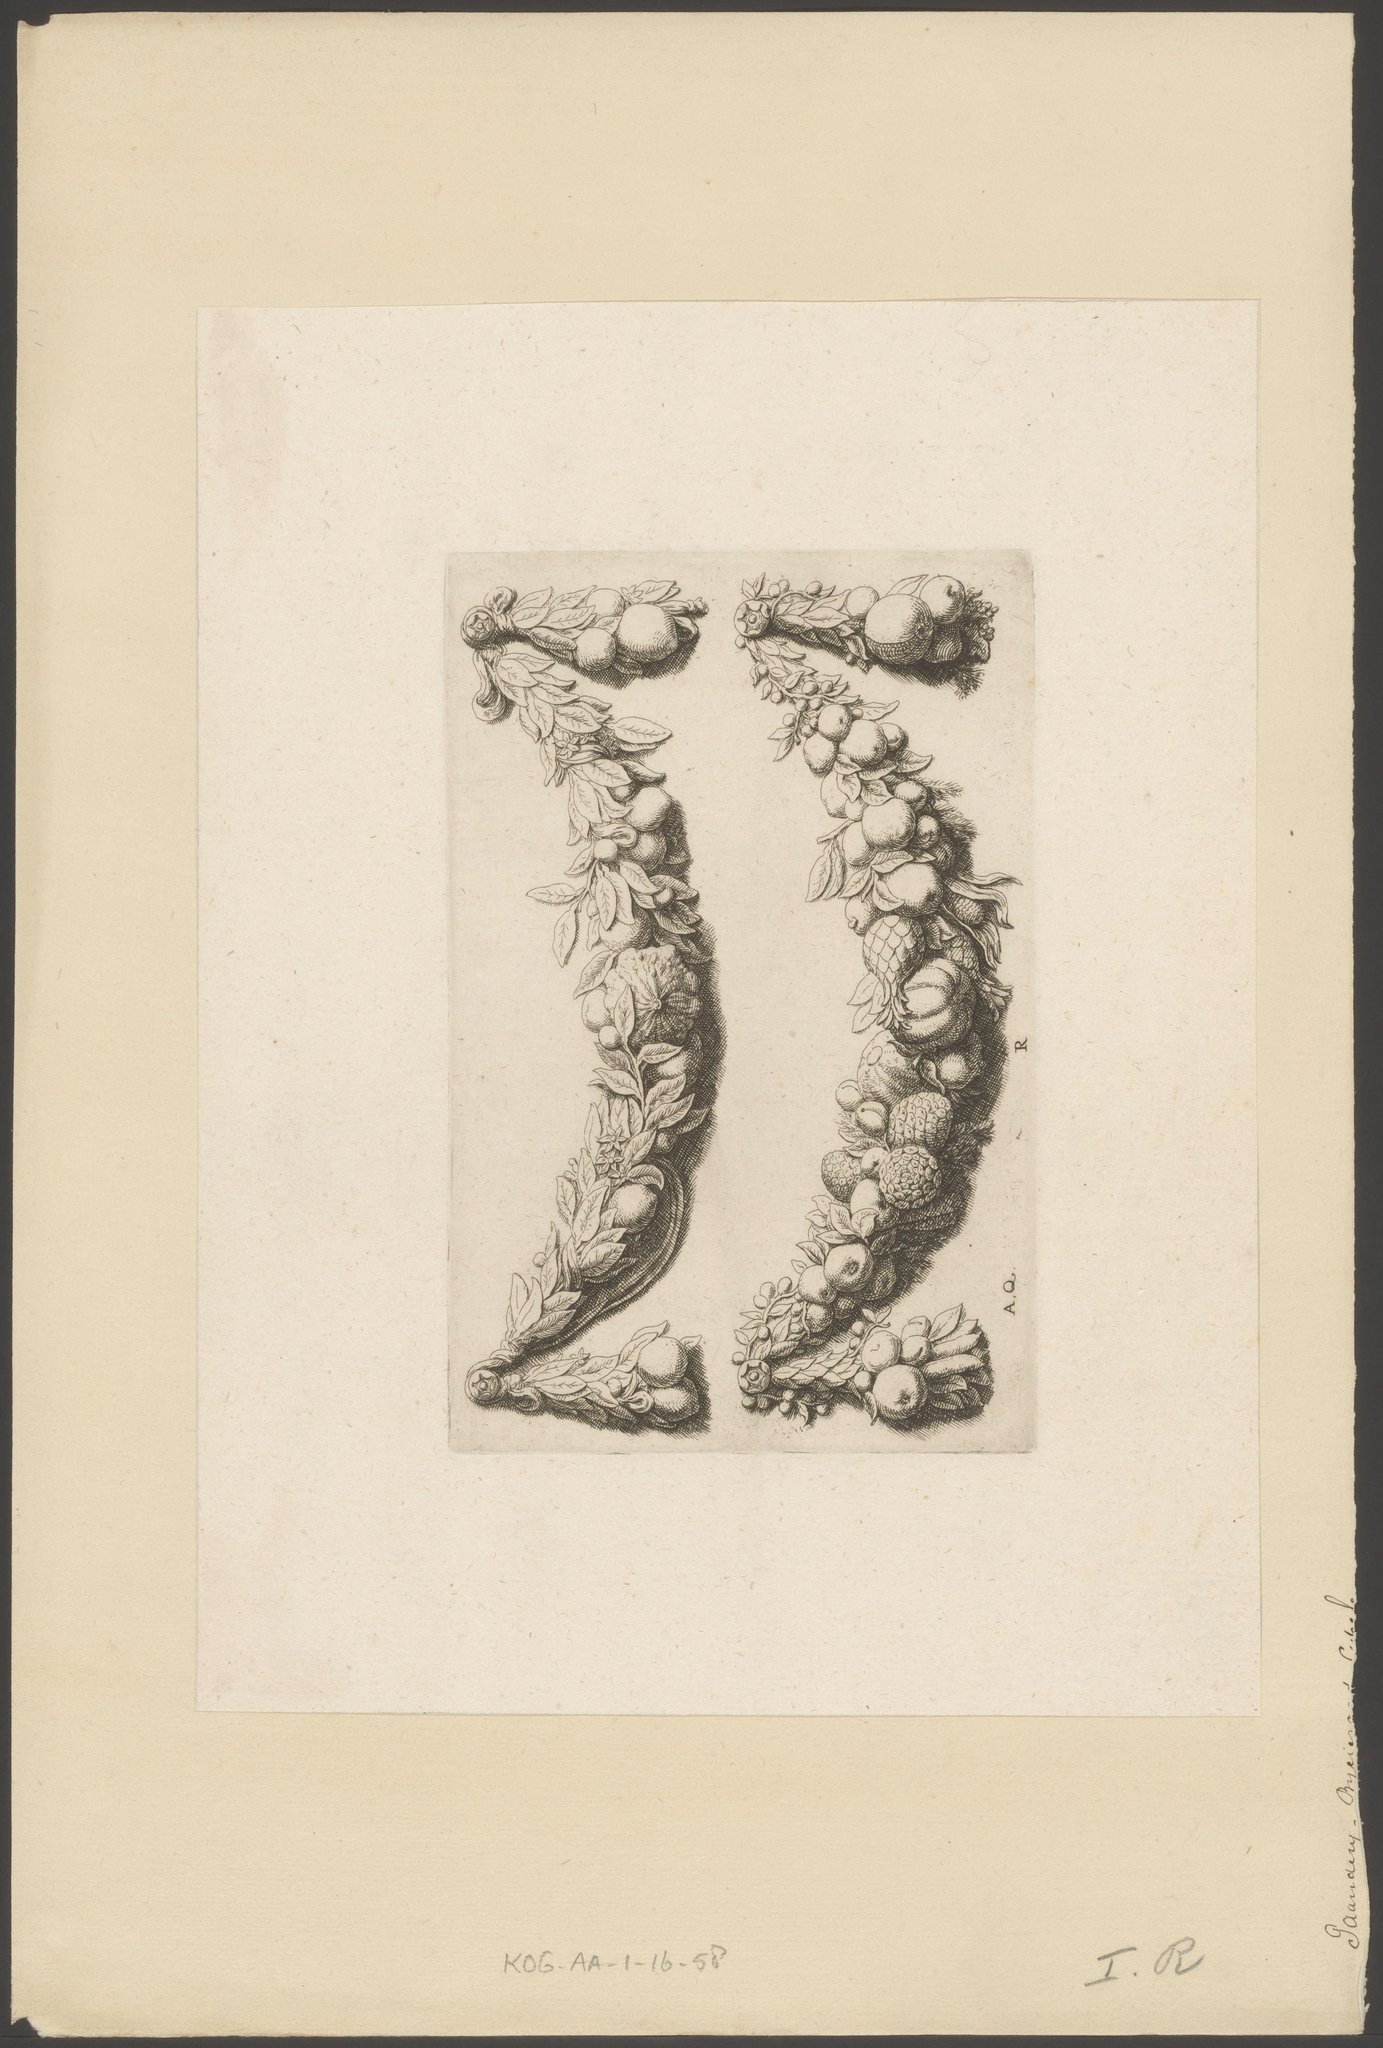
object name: print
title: Twee festoenen met fruit en bladeren in de oostelijke galerij van het Stadhuis op de Dam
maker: hubert quellinus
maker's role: print maker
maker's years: 1619-1687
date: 1655-1665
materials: paper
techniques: engraving, etching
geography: amsterdam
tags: fruits and vegetables ~ ornament, townhall, ornament ~ festoon, garland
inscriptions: collector's mark: ‘16,58’ Lugt 1641b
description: Prent gebruikt in: Prima pars. Praecipuarum effigierum ac ornamentorum, amplissimae Curiae Amstelrodamensis (…) / Het eerste deel. Van de voornaemste Statuen ende Ciraten, vant konstijck Stadhuys van Amstelredam, tmeeste in marmer gemaeckt, door Artus Quellinus, Beelthouwer der voorseyde Stadt / La Premier Partie. De plusieurs Figures et ornements, de la Maison de Ville d'Amsterdam (…). Amsterdam: Artus Quellinus (I), 1655. Zie RP-P-AO-22-1-1 voor bijhorende titelpagina. Zie RP-P-AO-22-1-2 voor bijhorend register. Zie RP-P-AO-22-1A, RP-P-AO-22-1B, RP-P-AO-22-1C, RP-P-AO-22-1D-1, RP-P-AO-22-1D-2, RP-P-AO-22-1E, RP-P-AO-22-1F, RP-P-AO-22-1G, RP-P-AO-22-1H, RP-P-AO-22-1I, RP-P-AO-22-1K-1, RP-P-AO-22-1K-2, RP-P-AO-22-1K-3, RP-P-AO-22-1K-4, RP-P-AO-22-1K-5, RP-P-AO-22-1L-1, RP-P-AO-22-1L-2, RP-P-AO-22-1M-1, RP-P-AO-22-1M-2, RP-P-AO-22-1N-1, RP-P-AO-22-1N-2, RP-P-AO-22-1N-3, RP-P-AO-22-1N-4, RP-P-AO-22-1N-5, RP-P-AO-22-1O-1, RP-P-AO-22-1O-2, RP-P-AO-22-1O-3, RP-P-AO-22-1O-4, RP-P-AO-22-1P-1, RP-P-AO-22-1P-2, RP-P-AO-22-1P-3, RP-P-AO-22-1P-4, RP-P-AO-22-1Q-1, RP-P-AO-22-1Q-2, RP-P-AO-22-1Q-3, RP-P-AO-22-1Q-4, RP-P-AO-22-1R-1, RP-P-AO-22-1R-2, RP-P-AO-22-1R-3, RP-P-AO-22-1R-5, RP-P-AO-22-1S-1, RP-P-AO-22-1S-2, RP-P-AO-22-1S-3, RP-P-AO-22-1S-4, RP-P-AO-22-1S-5, RP-P-AO-22-1T-1 en RP-P-AO-22-1T-2 voor andere prenten uit deze publicatie. Zelfde staat van prent ook gebruikt in: Prima pars. Praecipuarum effigierum ac ornamentorum, amplissimae Curiae Amstelrodamensis (…) / Het eerste deel. Van de voornaemste Statuen ende Ciraten, vant konstijck Stadhuys van Amstelredam, tmeeste in marmer gemaeckt, door Artus Quellinus, Beelthouwer der voorseyde Stadt / La Premier Partie. De plusieurs Figures et ornements, de la Maison de Ville d'Amsterdam (…). Amsterdam: Frederik de Wit, 1665. Latere staat van prent ook gebruikt in: Architecture peinture et sculpture de la Maison de Ville d'Amsterdam, representee en CIX. figures en taille-douce (…). Amsterdam: David Mortier, 1719. En in: Architecture peinture et sculpture de la Maison de Ville d'Amsterdam, representee en CIX. figures en taille-douce (…). Amsterdam: Gerard Valck, 1719. En in: Bouw schilder en beeldhouwkonst, van het Stadhuis te Amsteldam, vertoont in CIX figuuren (…). Amsterdam: Covens & Mortier & Covens Jr., s.a. (1774-1783).